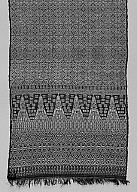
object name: cloth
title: Shoulder Cloth (Selendang)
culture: palembang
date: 1801-1900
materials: metal thread, silk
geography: indonesia